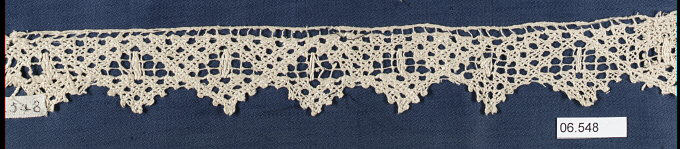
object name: edging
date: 1600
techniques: embroidery